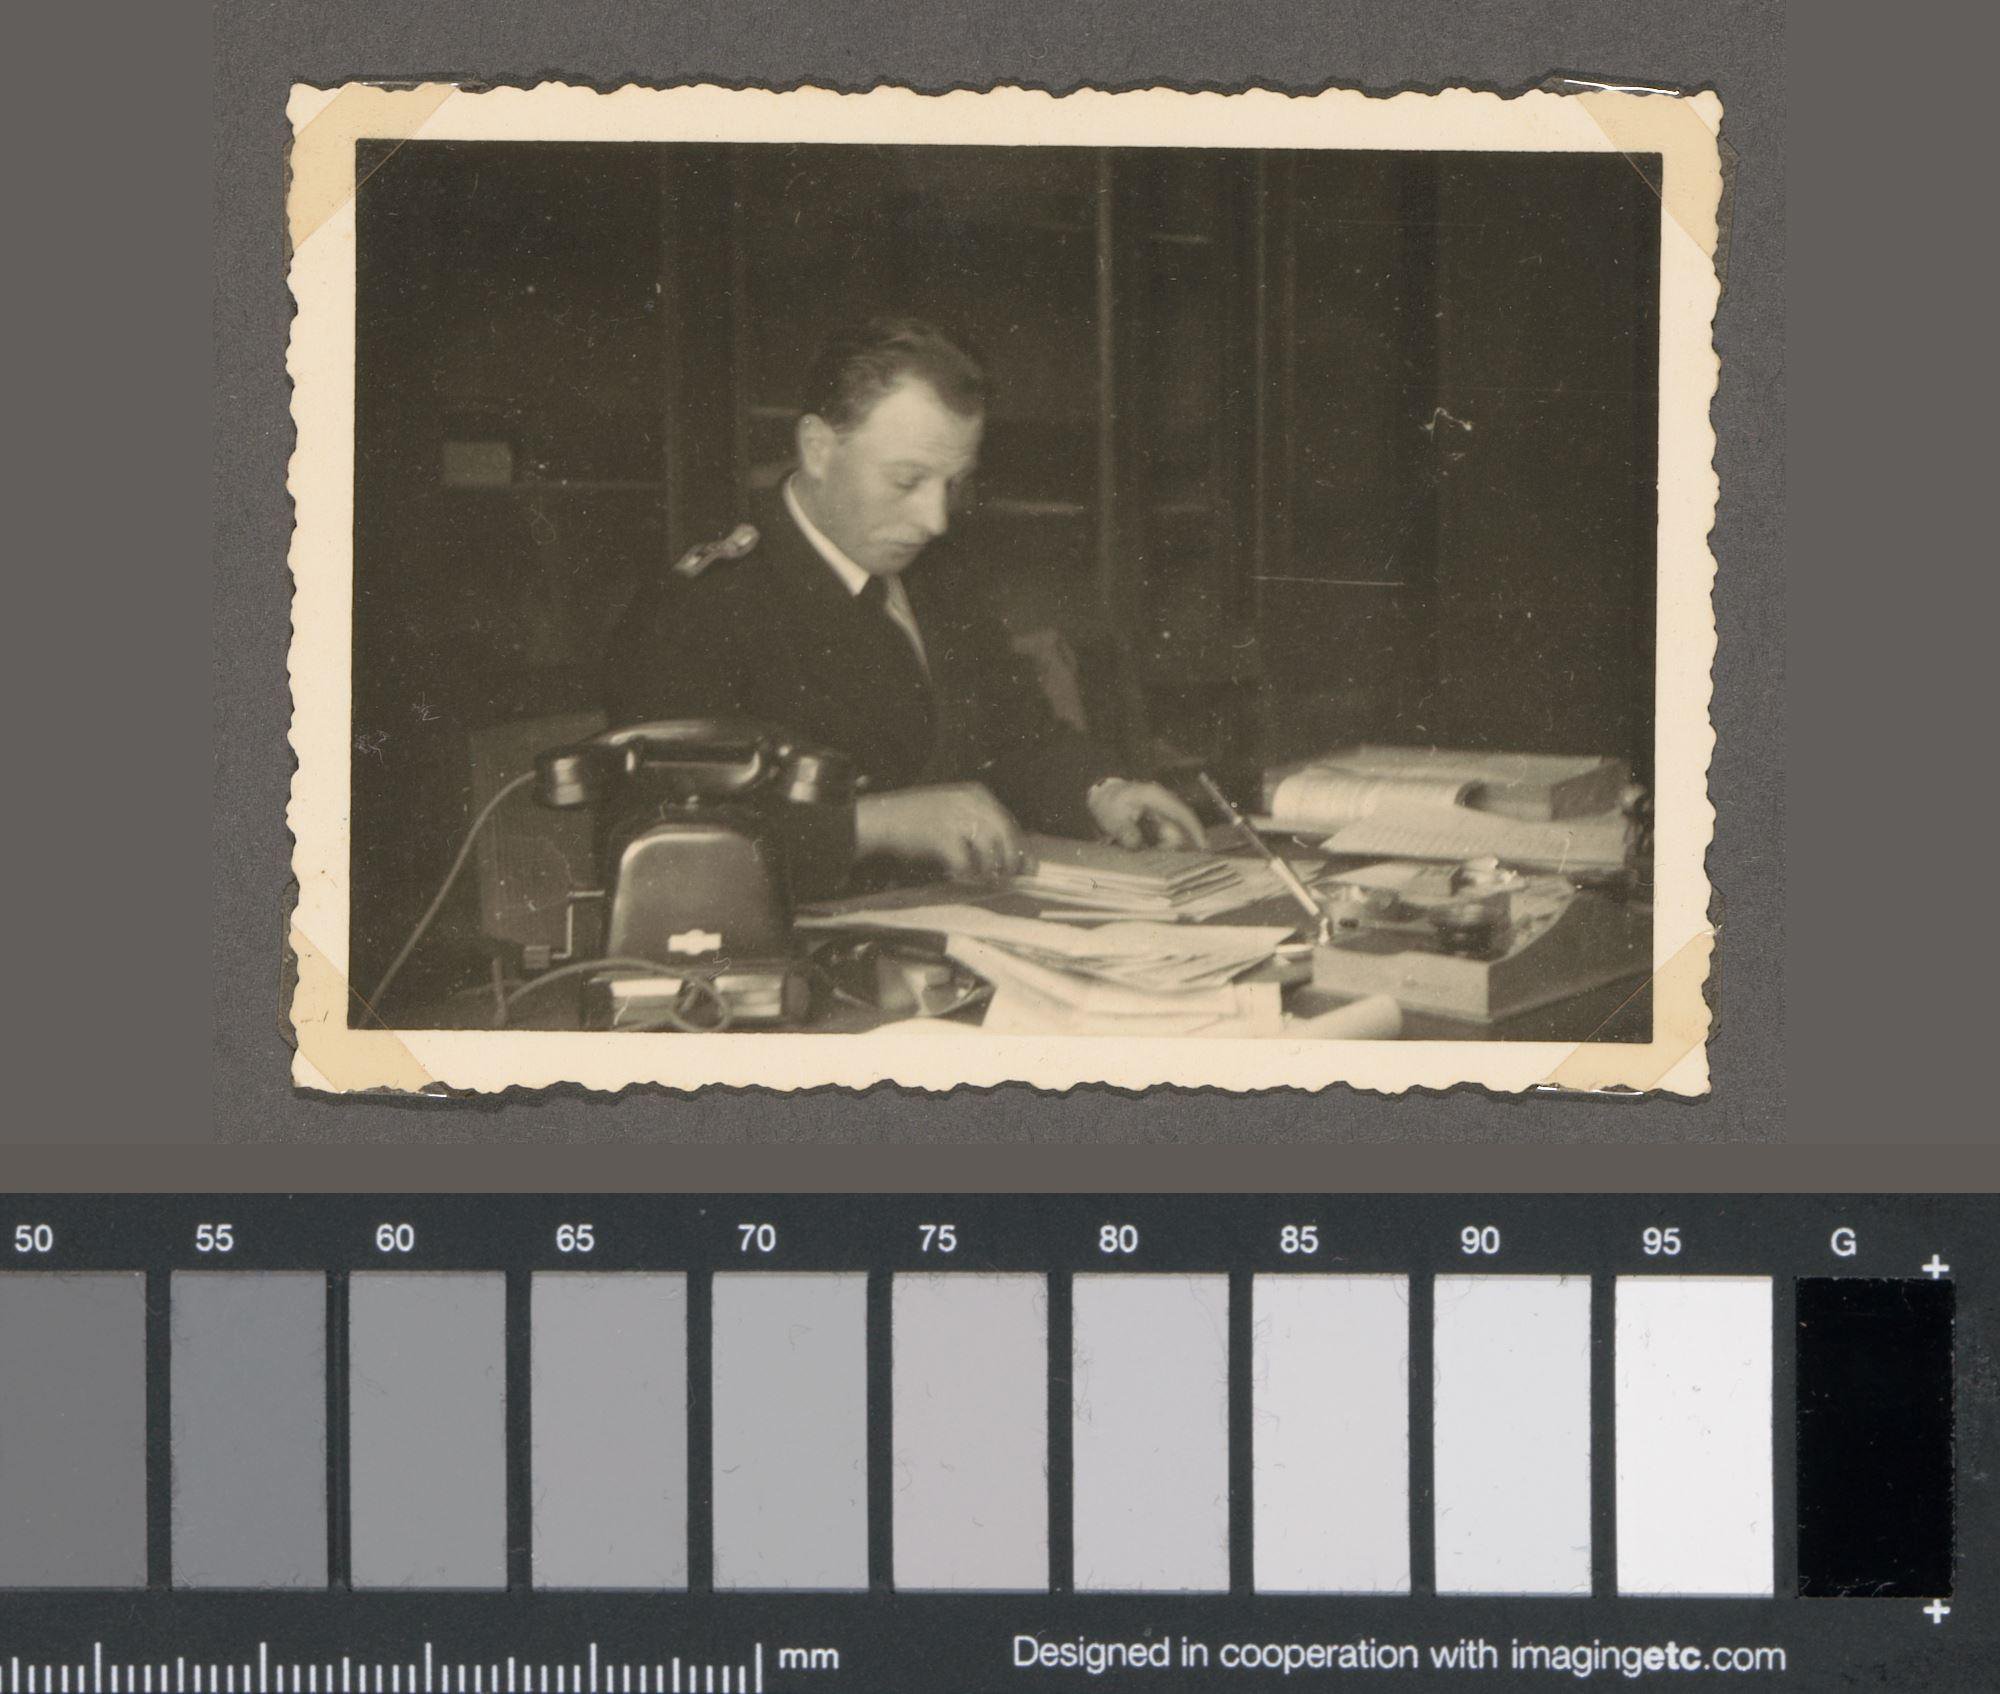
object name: photograph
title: Ob. Wm. Meyer achter een bureau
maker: Anonymous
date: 1941-1945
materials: paper, photographic support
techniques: gelatin silver print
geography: netherlands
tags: writing-table, writing-desk, historical persons, occupation ~ war, netherlands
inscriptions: annotation: ‘Ob. Wm. Meyer’, annotation: ‘DienststelleWachtmeisterei’